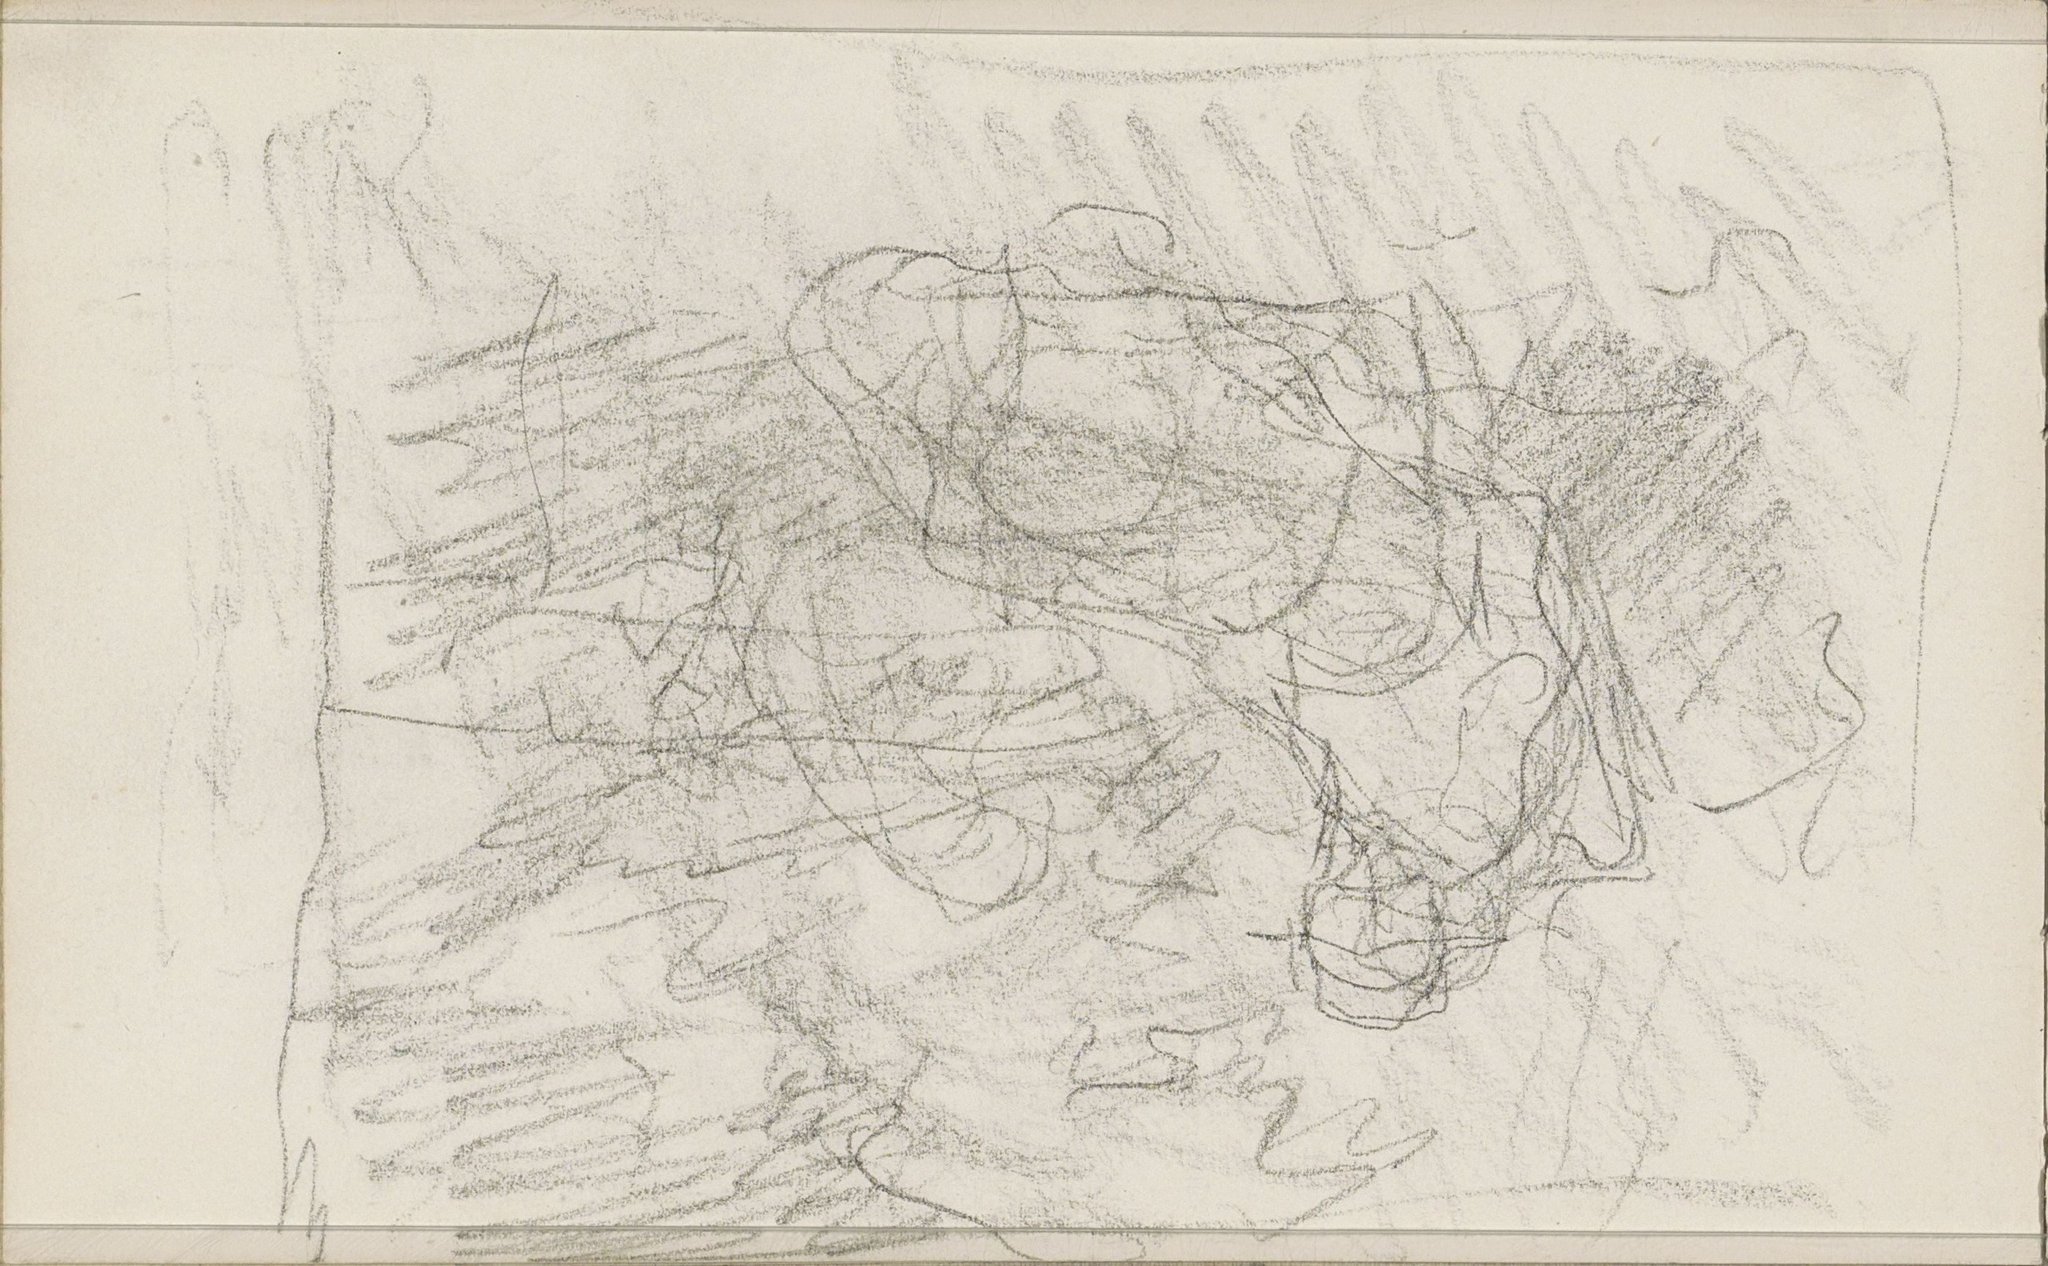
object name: sketchbook leaf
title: Zittende figuur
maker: anton mauve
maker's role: draughtsman, painter, print maker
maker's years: 1838-1888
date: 1848-1888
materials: chalk, paper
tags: sitting figure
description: Blad 4 verso uit een schetsboek met 41 bladen.